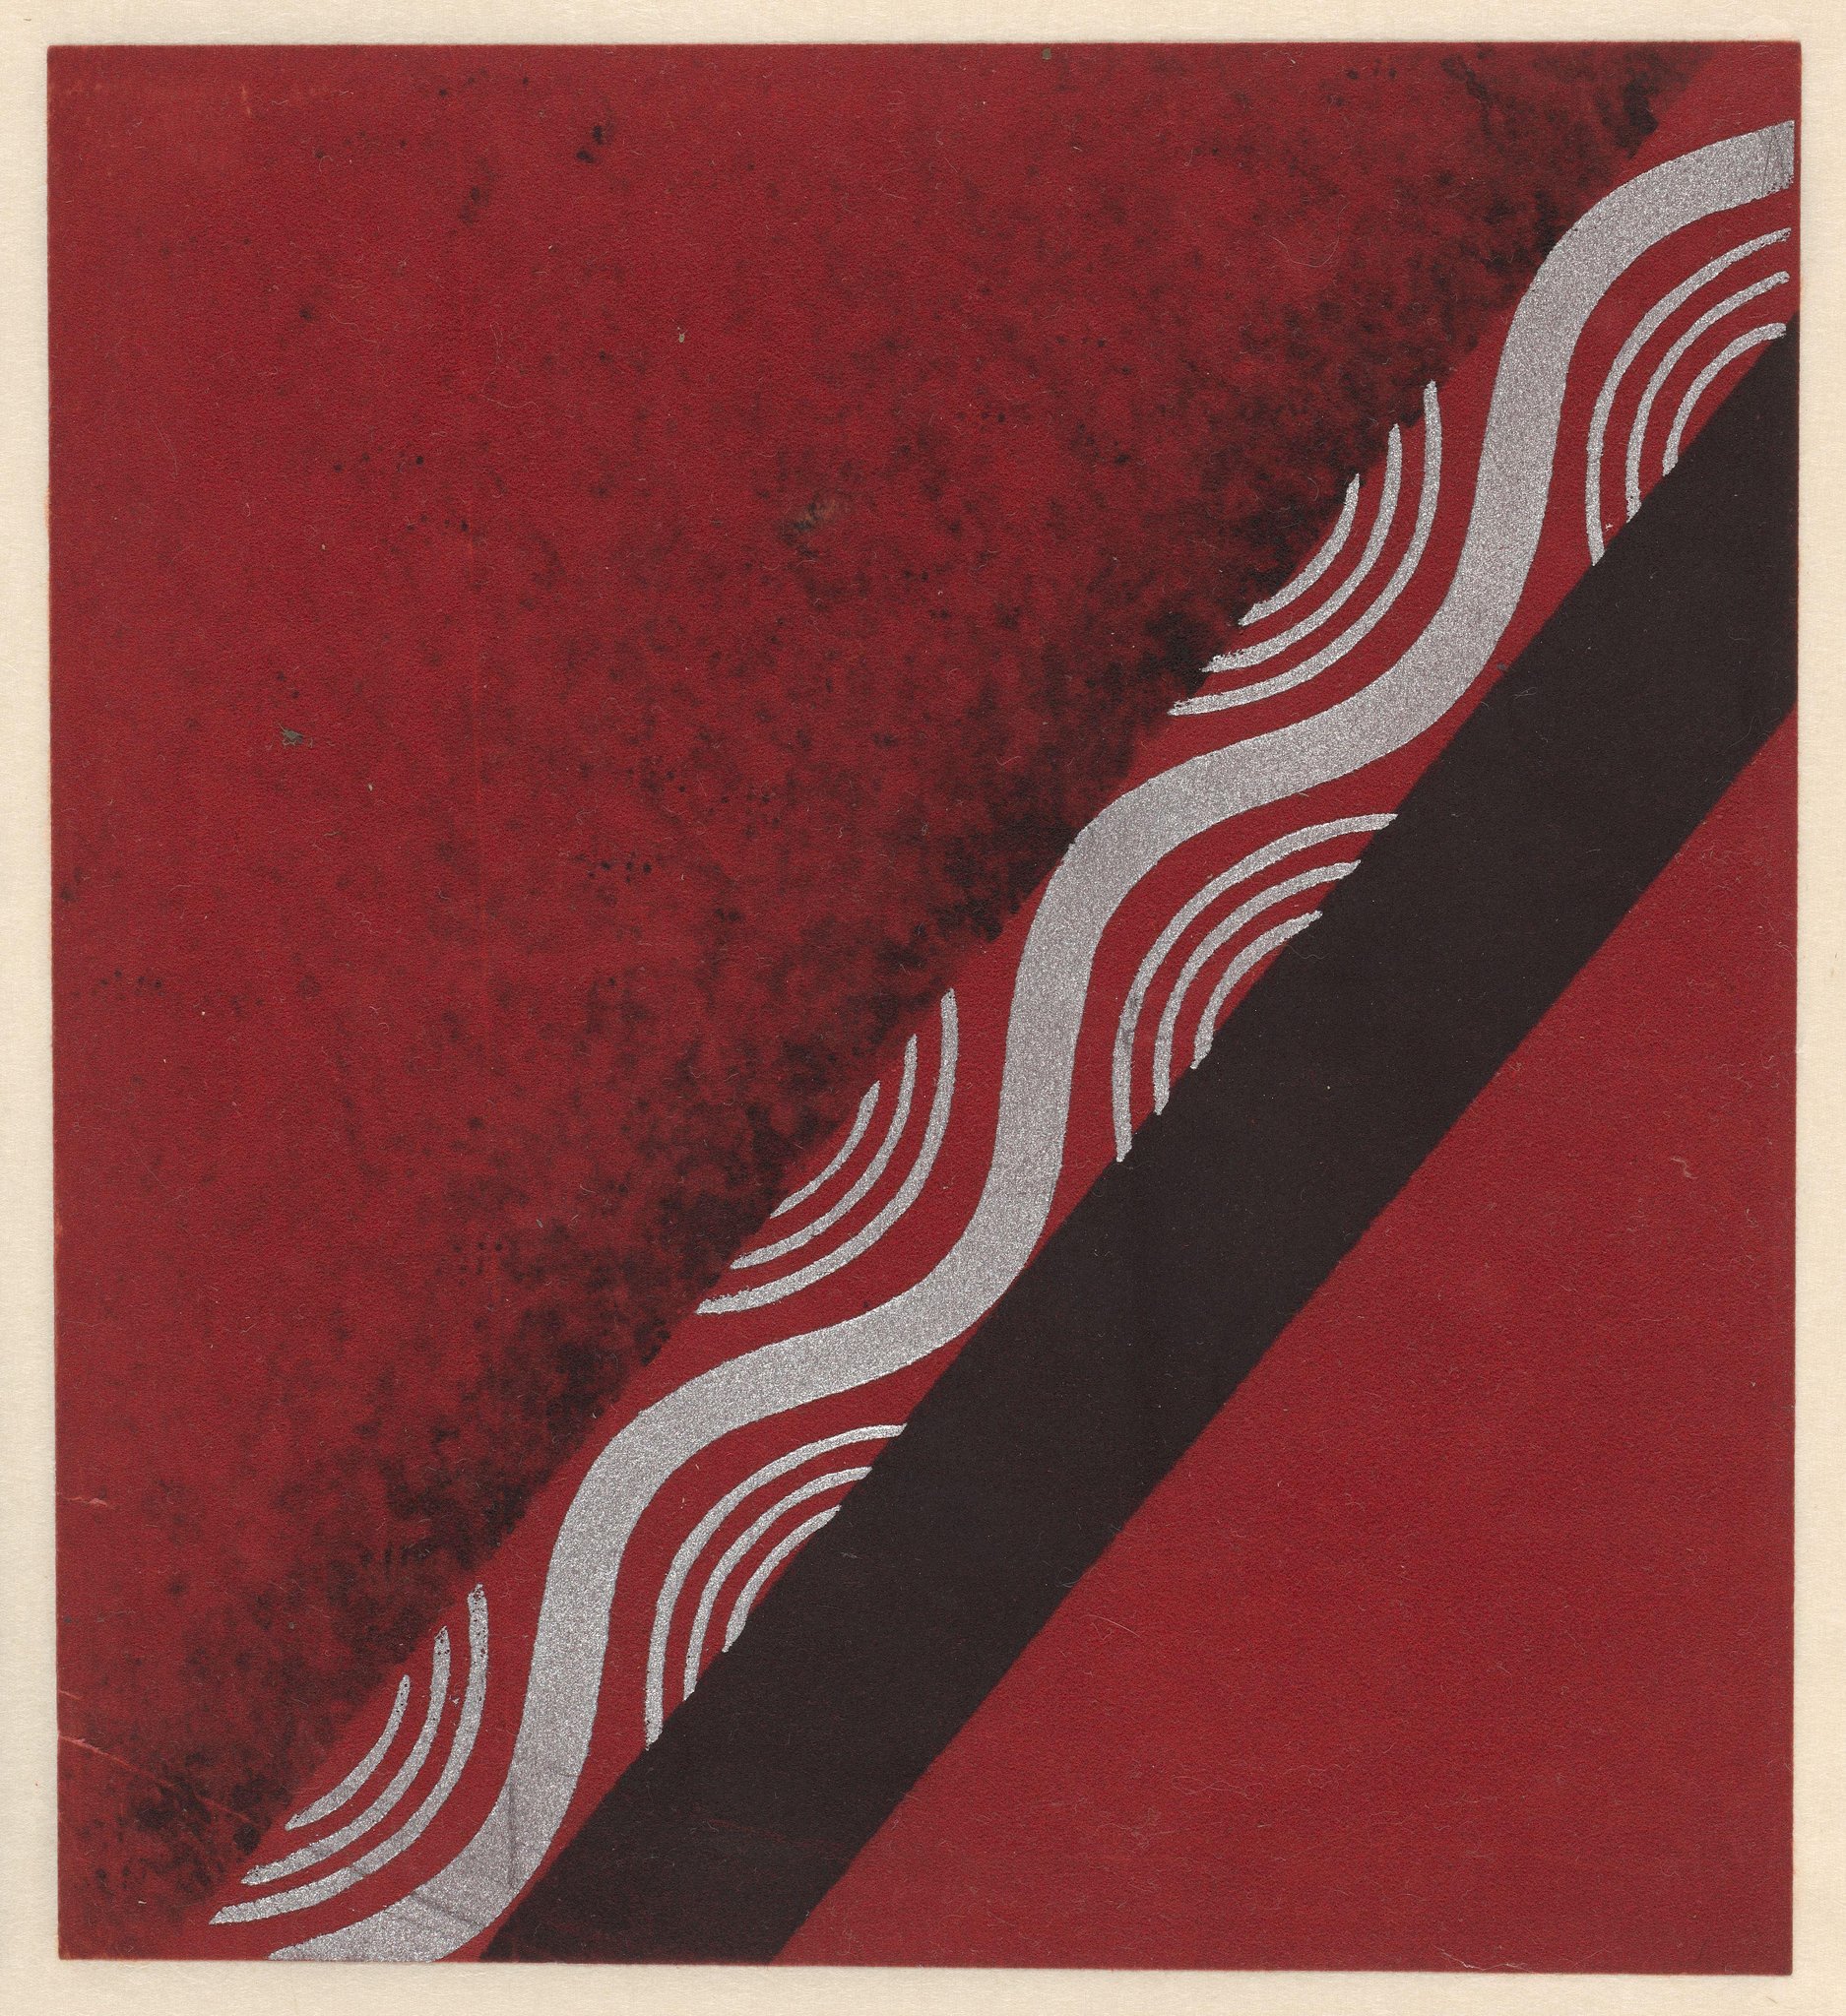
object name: design drawing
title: Ontwerp voor stof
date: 1920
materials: gouache, paper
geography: paris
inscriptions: stamp: ‘Léo TISSANDIÉ / Dessinateur / de Mode’